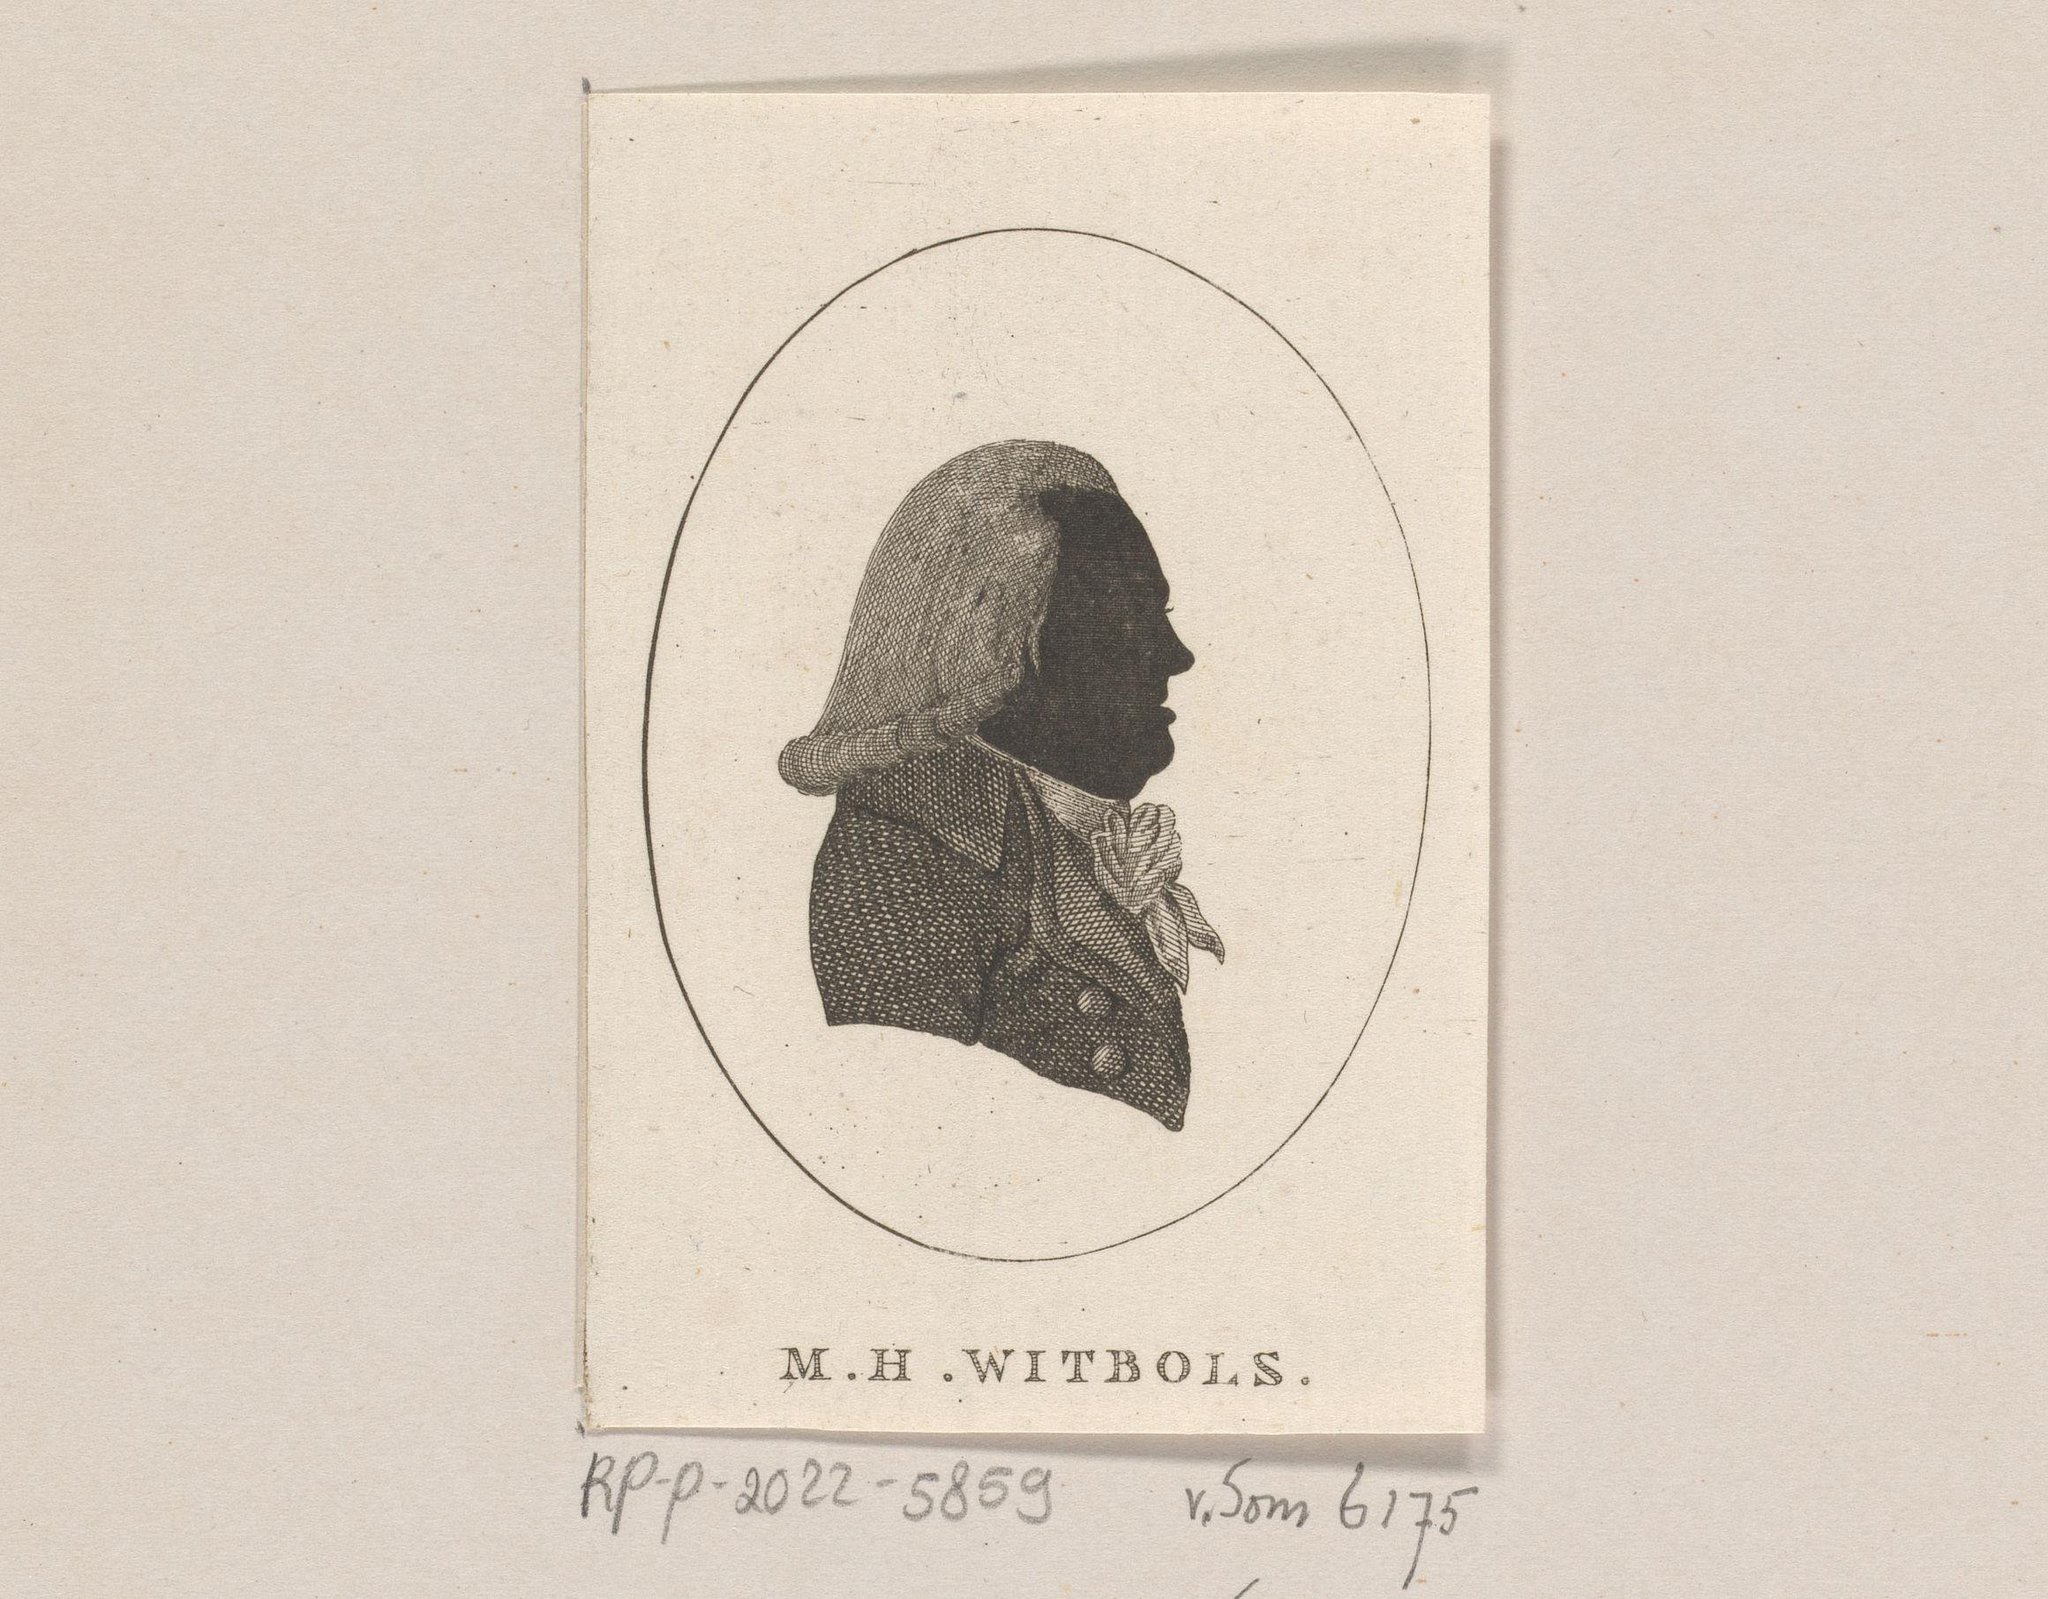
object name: print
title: Silhouetportret van Michaël Henricus Witbols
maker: antoni zürcher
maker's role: print maker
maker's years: 1754-1837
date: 1799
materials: paper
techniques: etching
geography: netherlands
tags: rotterdam, hierarchy of jurisdiction ~ roman catholic church, historical persons, politician, e.g. party leader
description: Prent waarschijnlijk uit: Rogge, Cornelius. Geschiedenis der staatsregeling, voor het Bataafsche volk. Amsterdam: Johannes Allart, 1799.